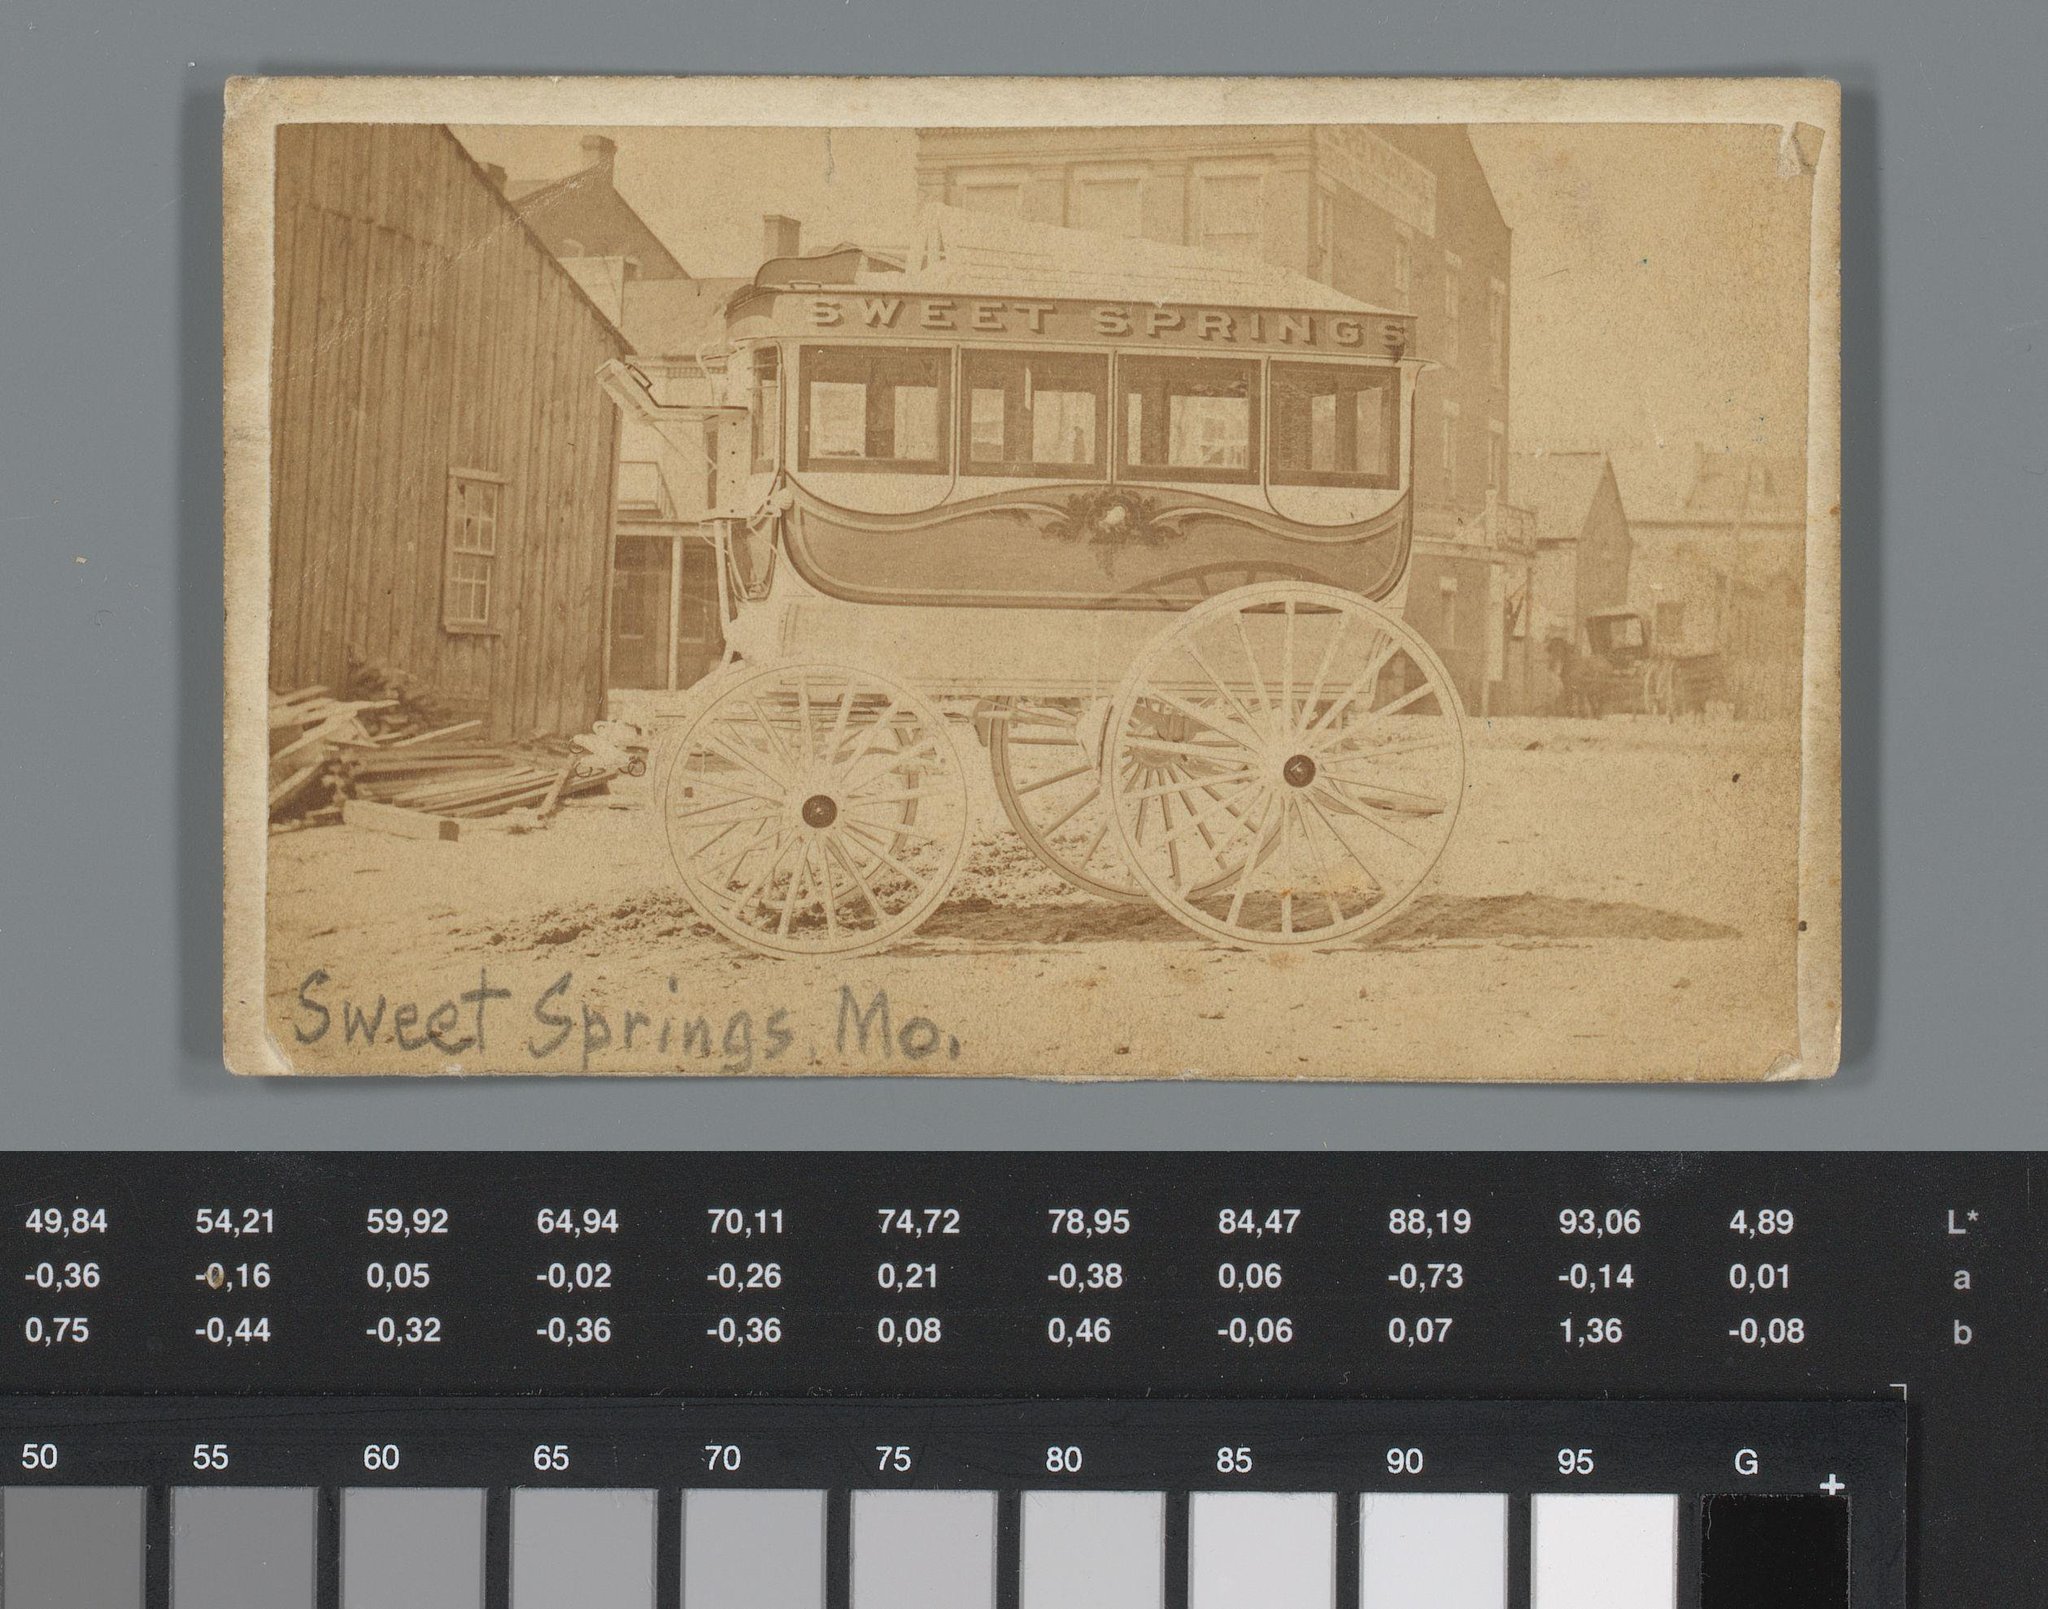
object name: carte de visite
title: Reclame voor wagens en rijtuigen van Andrew Wight te Saint Louis met gezicht op een omnibus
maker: Anonymous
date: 1850-1915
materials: cardboard, photographic support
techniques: albumen print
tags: diligence, omnibus, horse-tram, advertising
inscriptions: inscription: ‘Andrew Wight / MANUFACTURER OF / OMNIBUSES, STREET CARS, / EXPRESS, BUSINESS, REIGHT, CIRCUS WAGONS & CAGES / 2300 Broadway / ST. LOUIS, MO.’